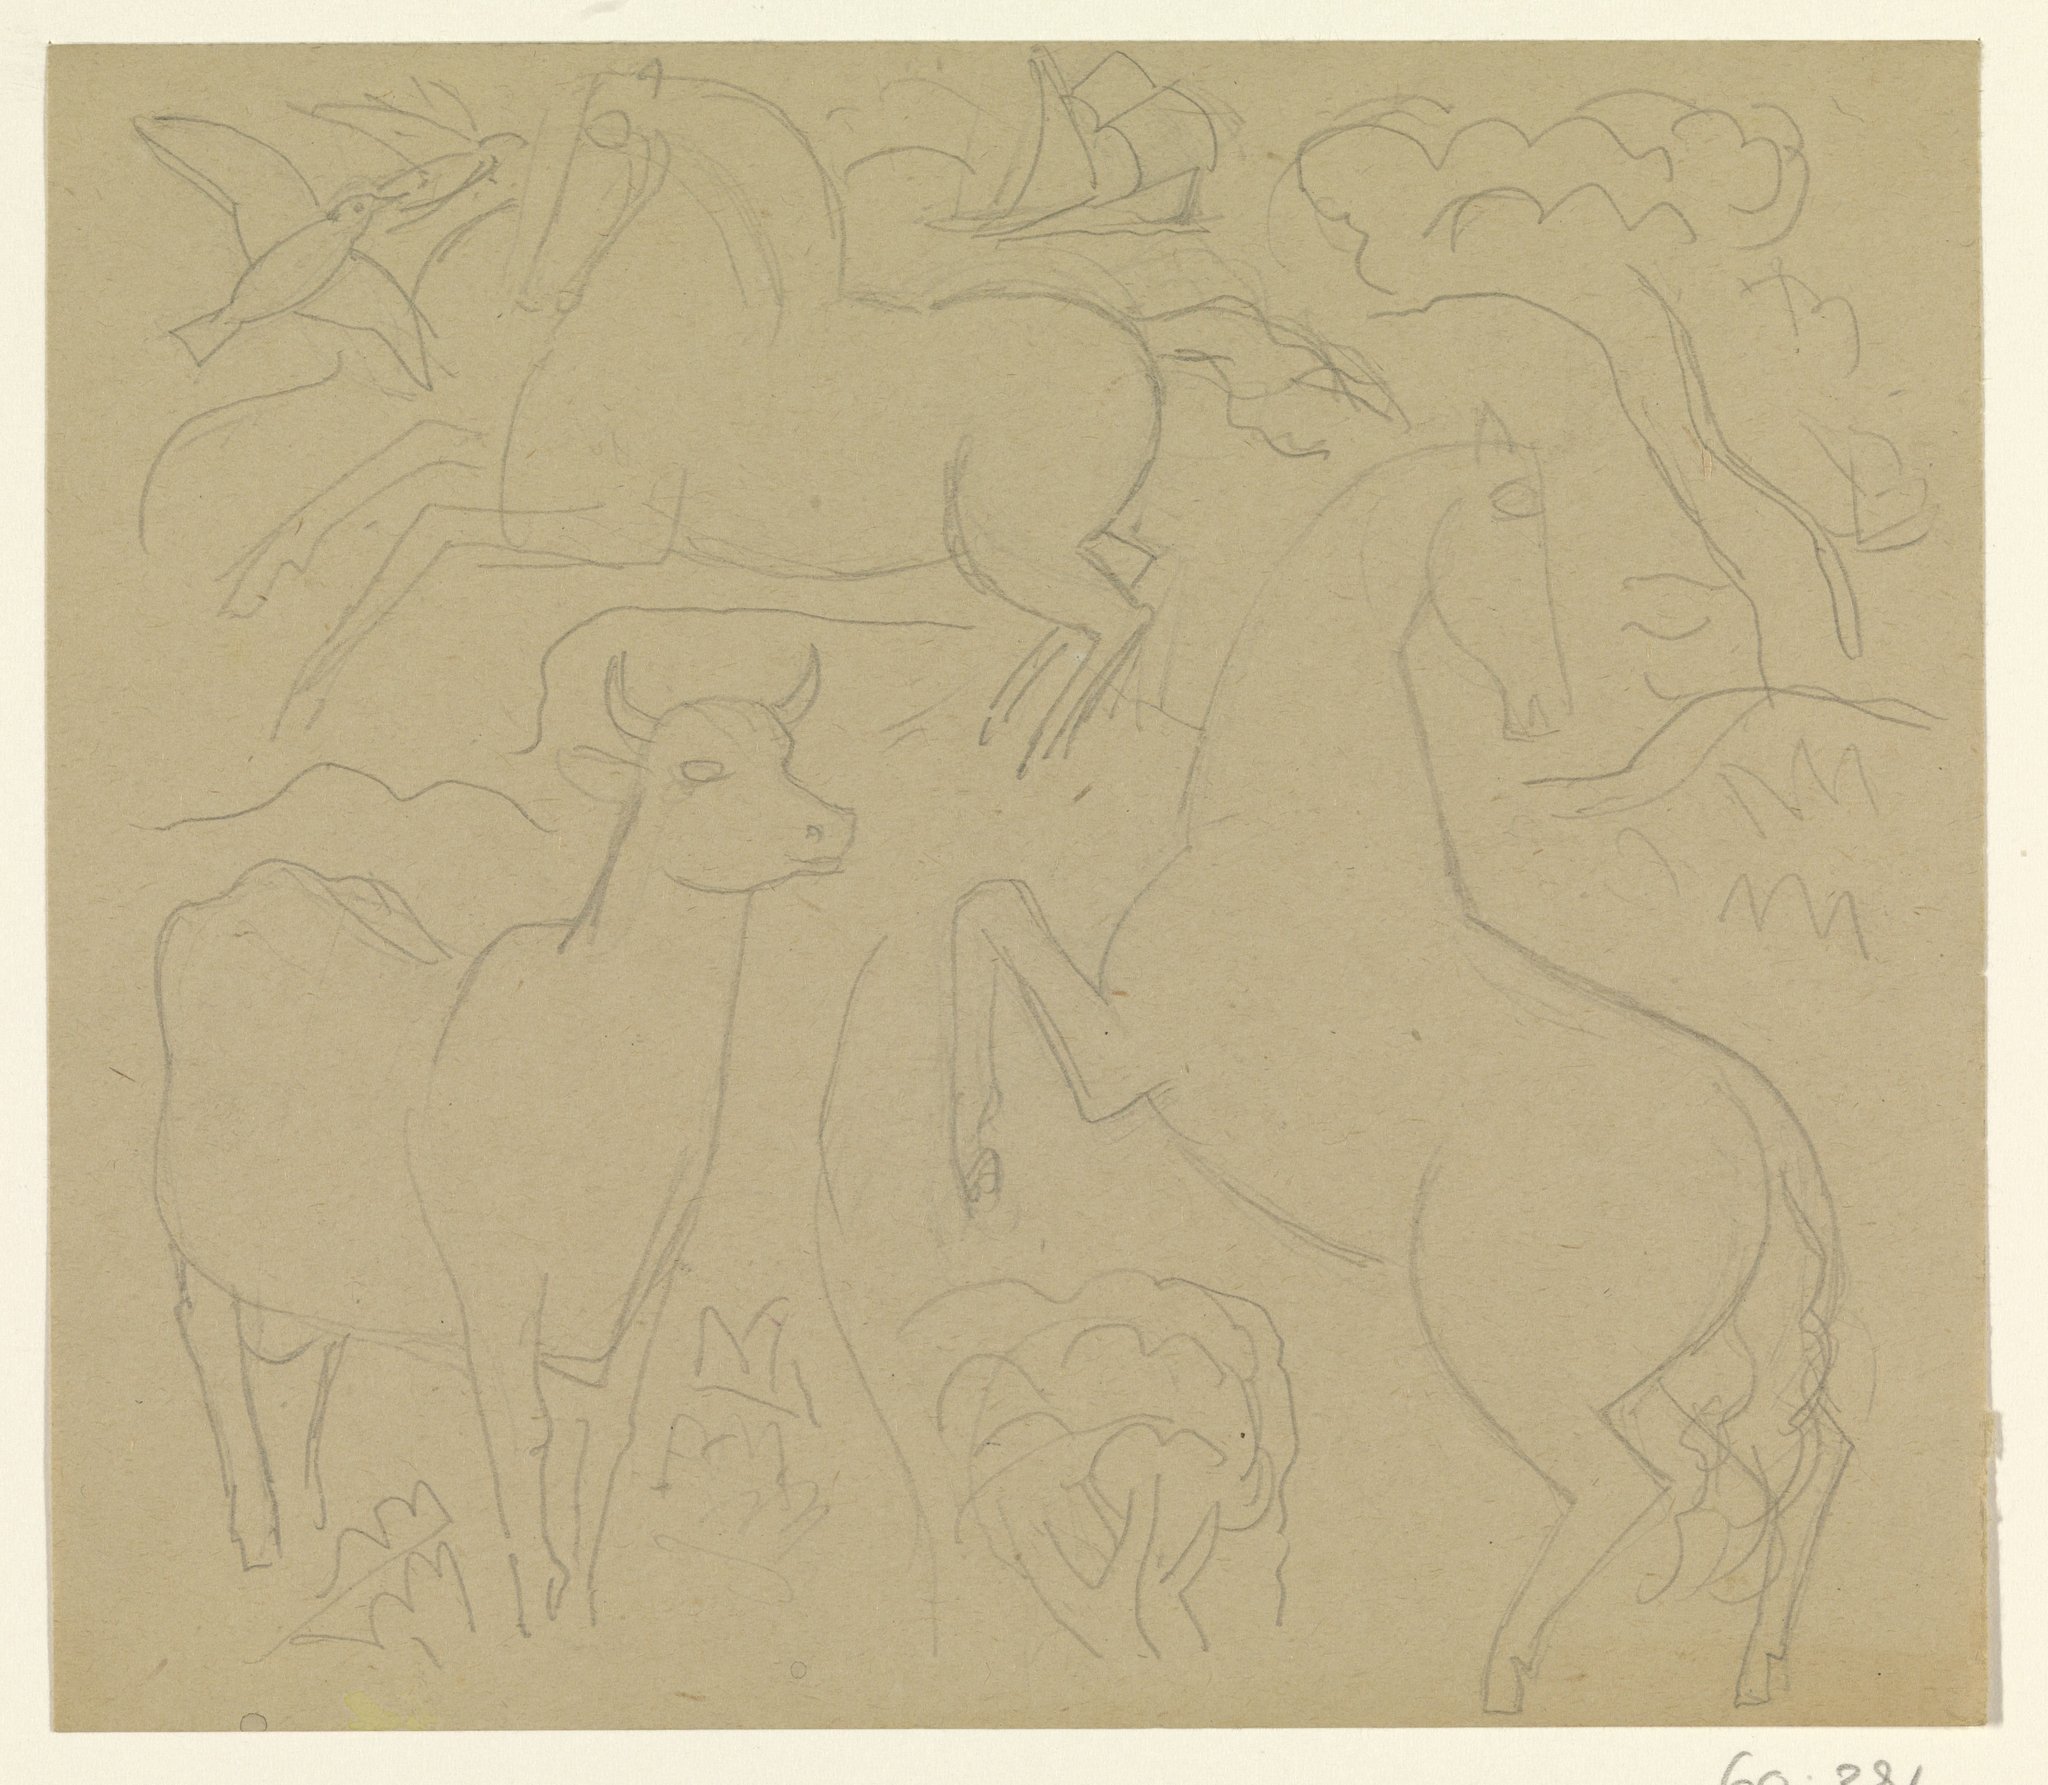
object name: drawing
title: Paarden en een koe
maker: leo gestel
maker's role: draughtsman, print maker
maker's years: 1881-1941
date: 1891-1941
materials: paper, pencil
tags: trees, cow, sailing-ship, sailing-boat, birds, horse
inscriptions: collector's mark: Lugt 2228